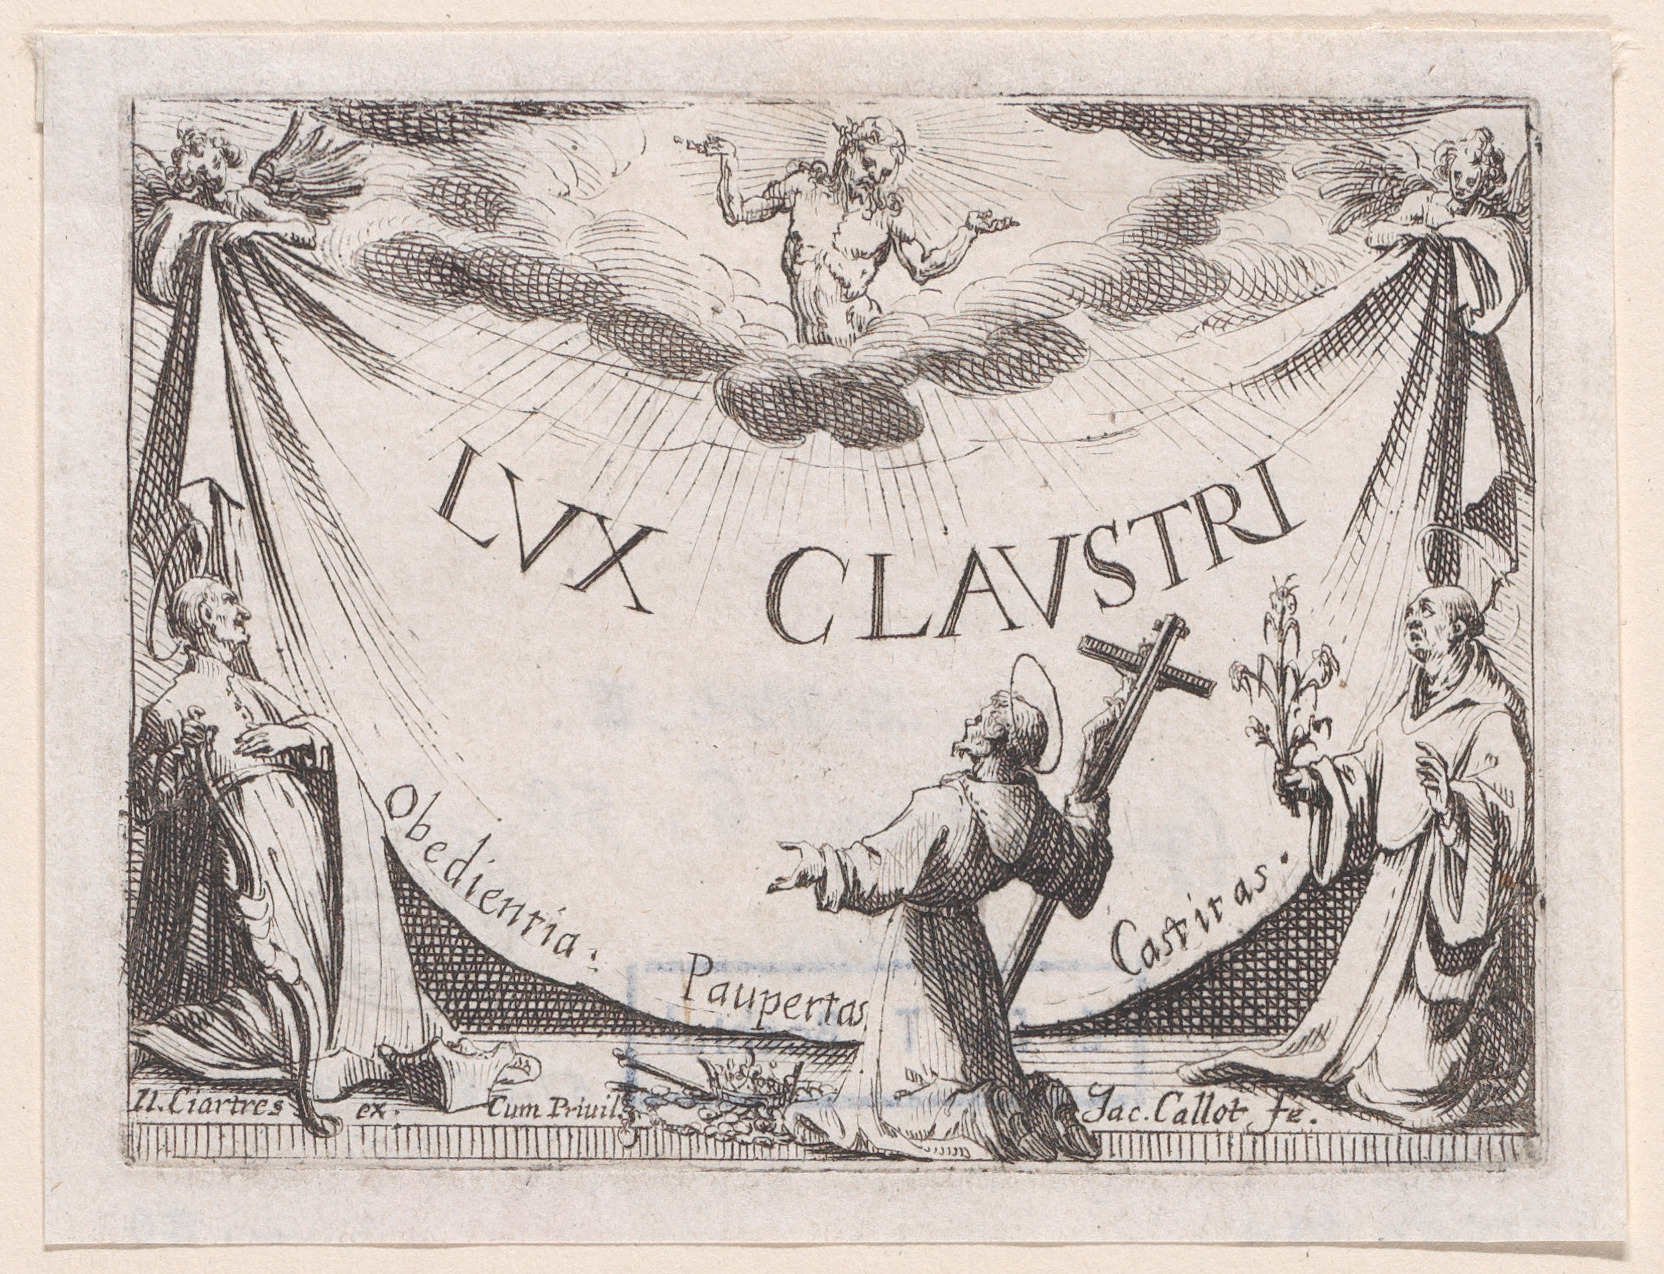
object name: print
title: Frontispiece, from "Lux Claustri ou La Lumière du Cloitre" (The Light of the Cloisters)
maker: jacques callot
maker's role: artist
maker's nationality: french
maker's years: 1592-1635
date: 1621-1635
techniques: etching